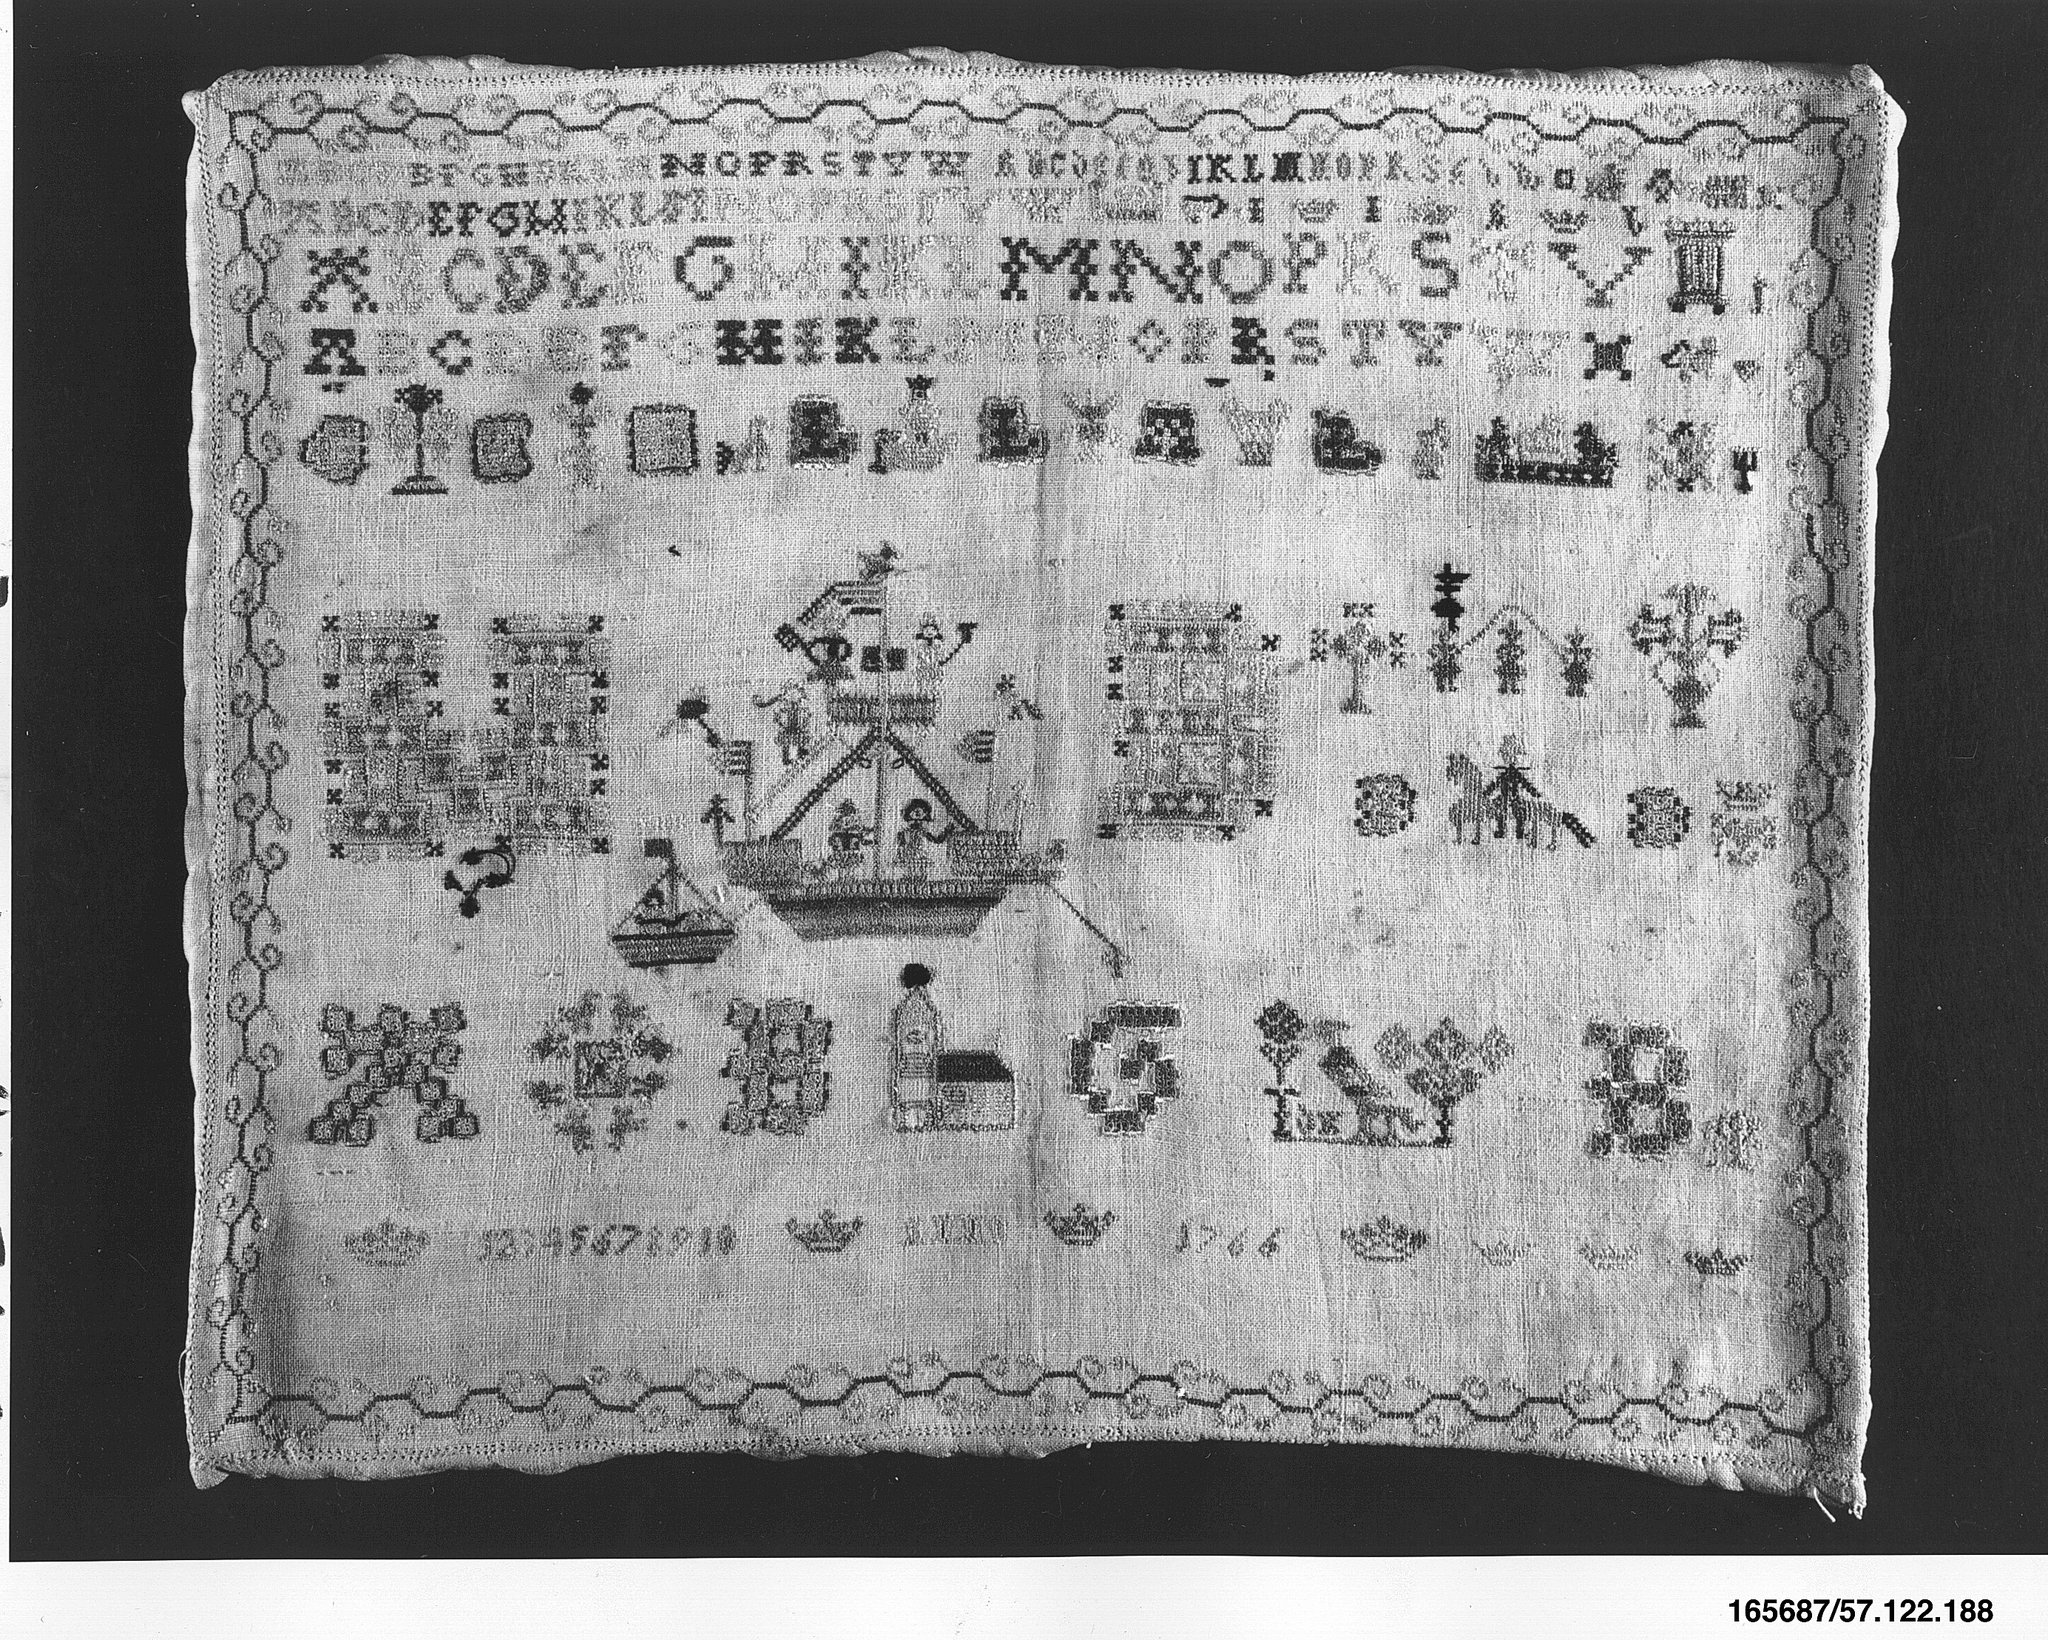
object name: sampler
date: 1766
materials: linen, silk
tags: ships